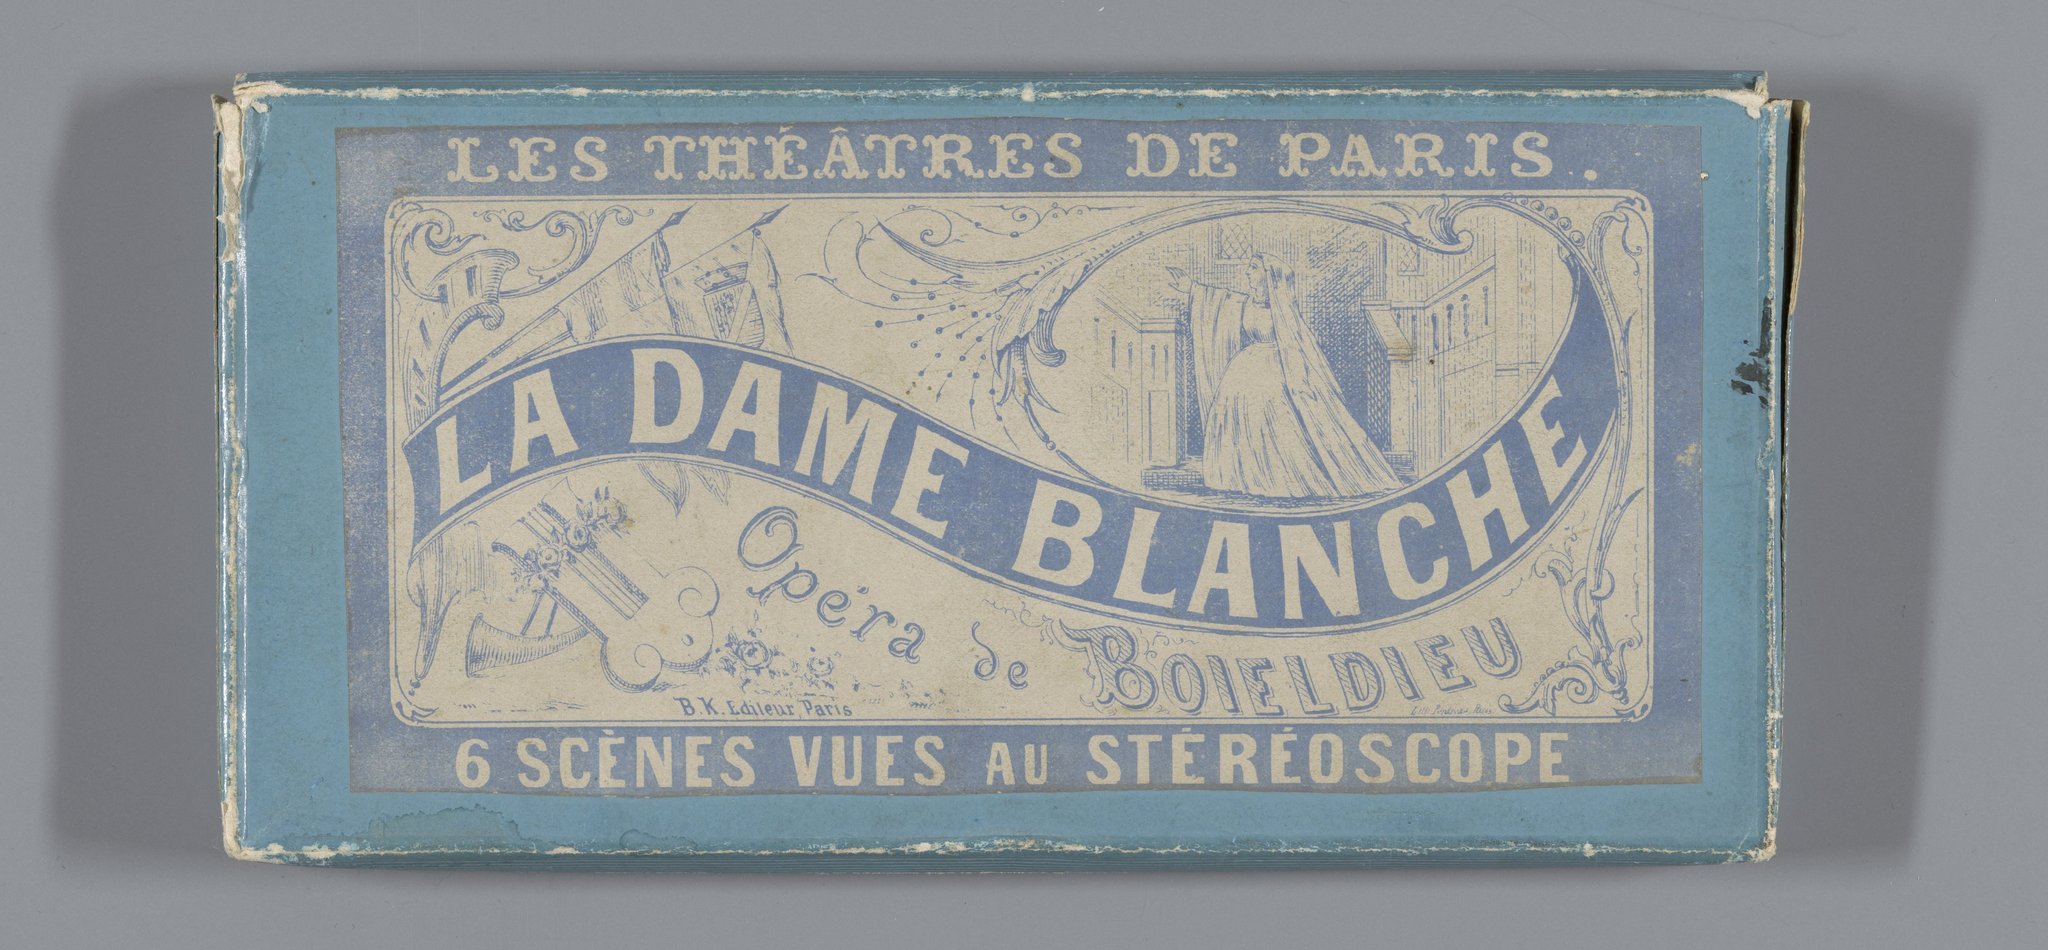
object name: box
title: Doos ter verpakking van 6 stereofoto's van het theater in Parijs La dame blanche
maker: Anonymous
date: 1867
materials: cardboard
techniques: printing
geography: paris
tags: theatre, theatrical performance, paris